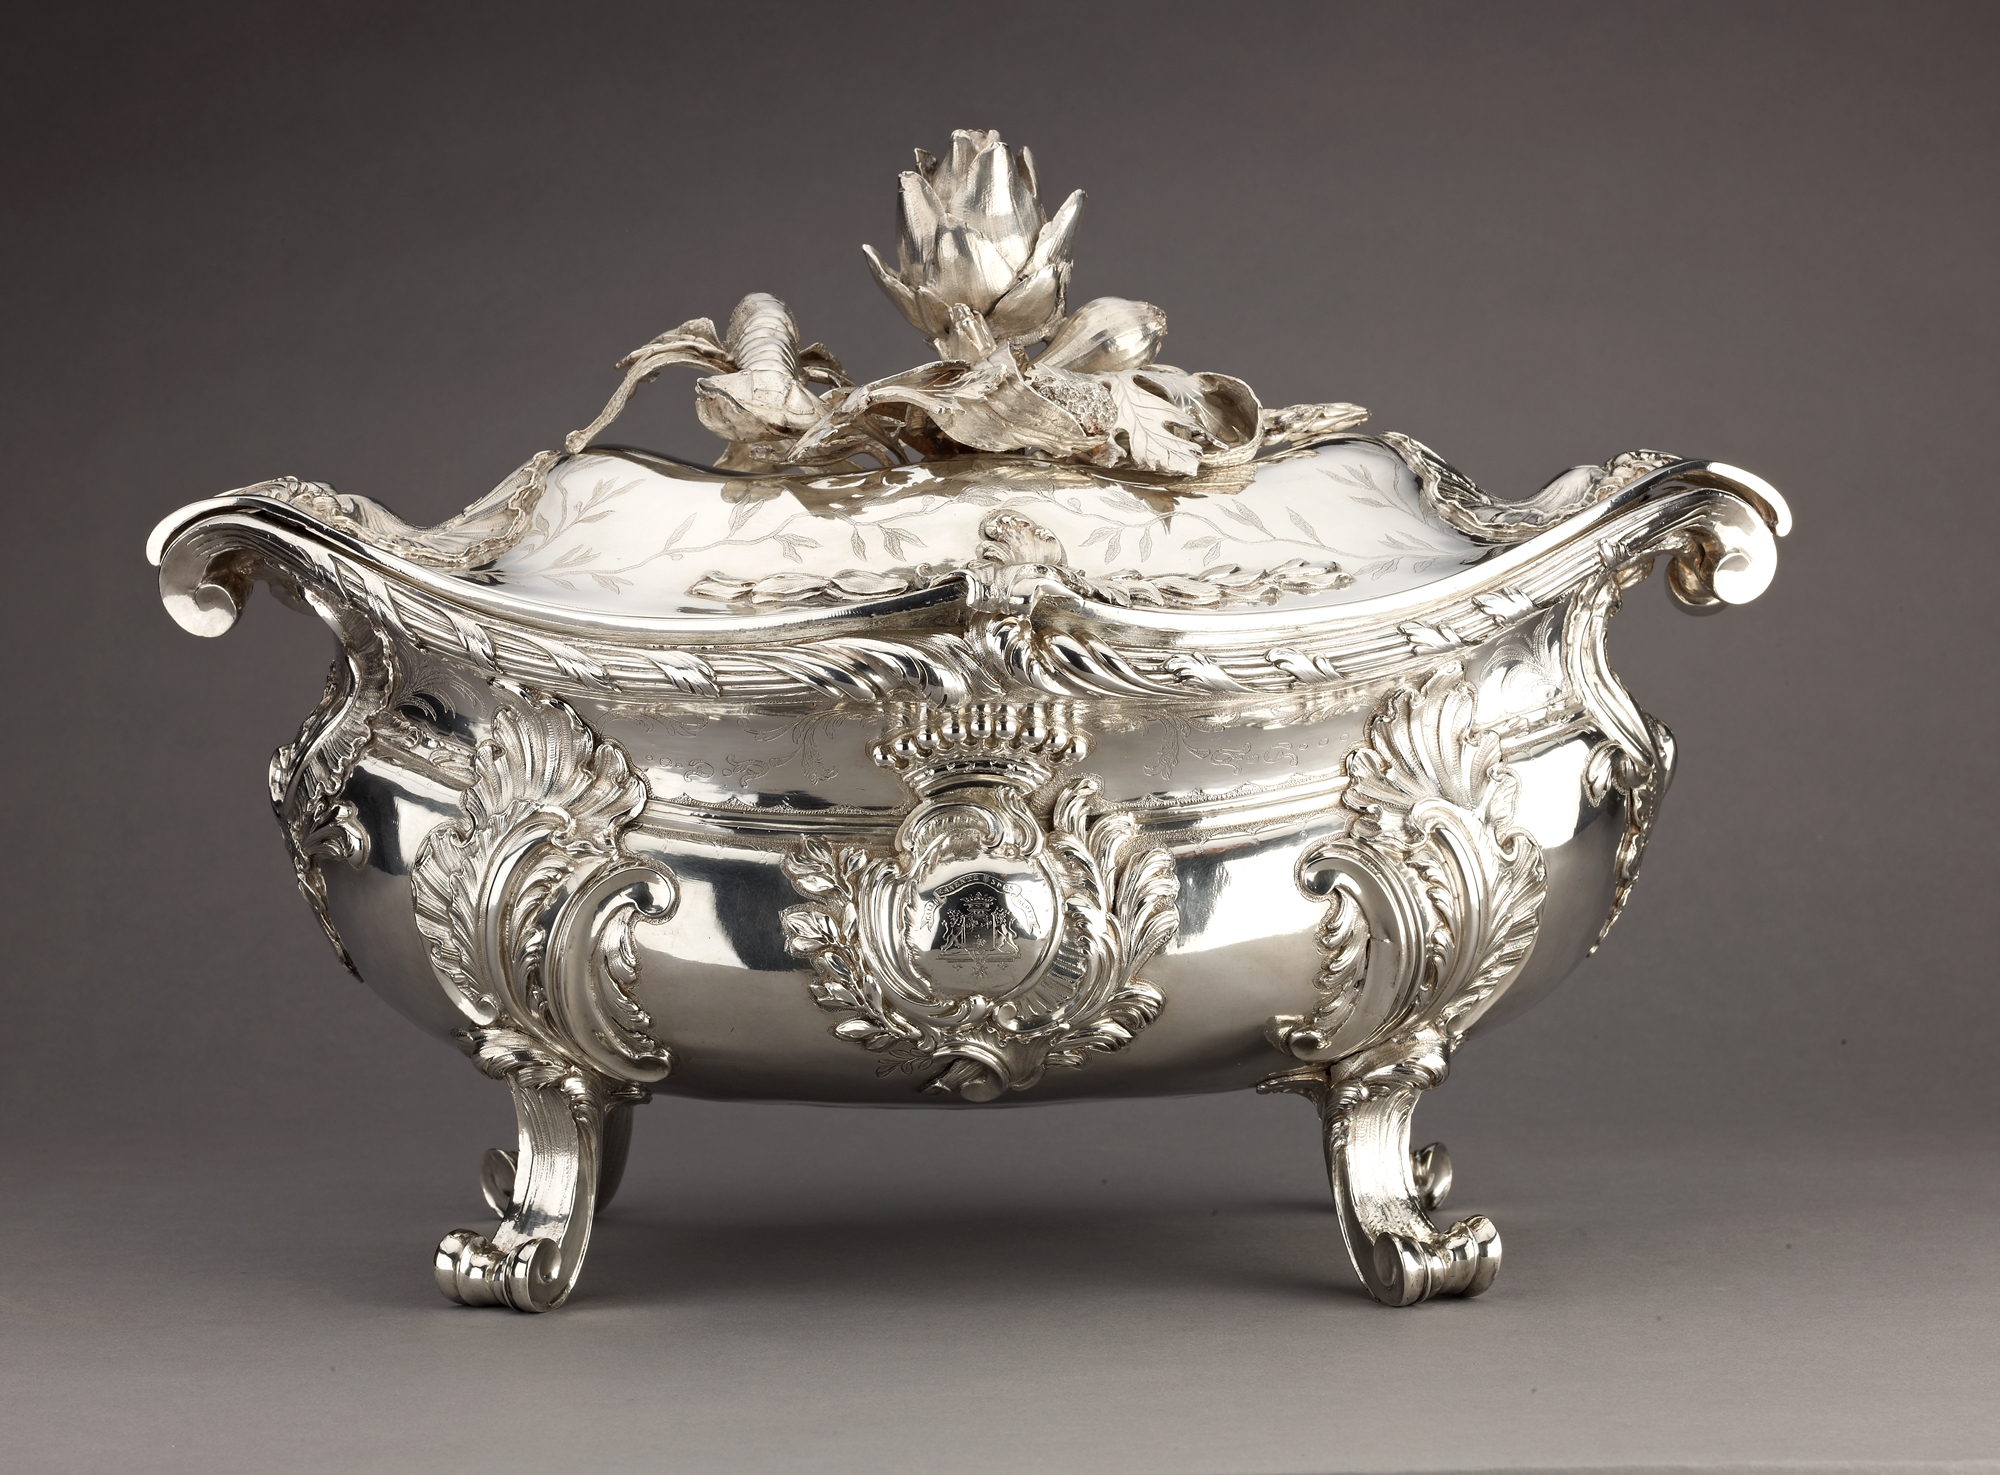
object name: tureen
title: Silver Tureen (a), lid (b) and liner (c) [pair with 1975.1.2561a,b]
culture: french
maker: etienne-jacques marcq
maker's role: artist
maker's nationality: french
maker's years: 1732-1781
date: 1749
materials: silver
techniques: casting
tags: coat of arms